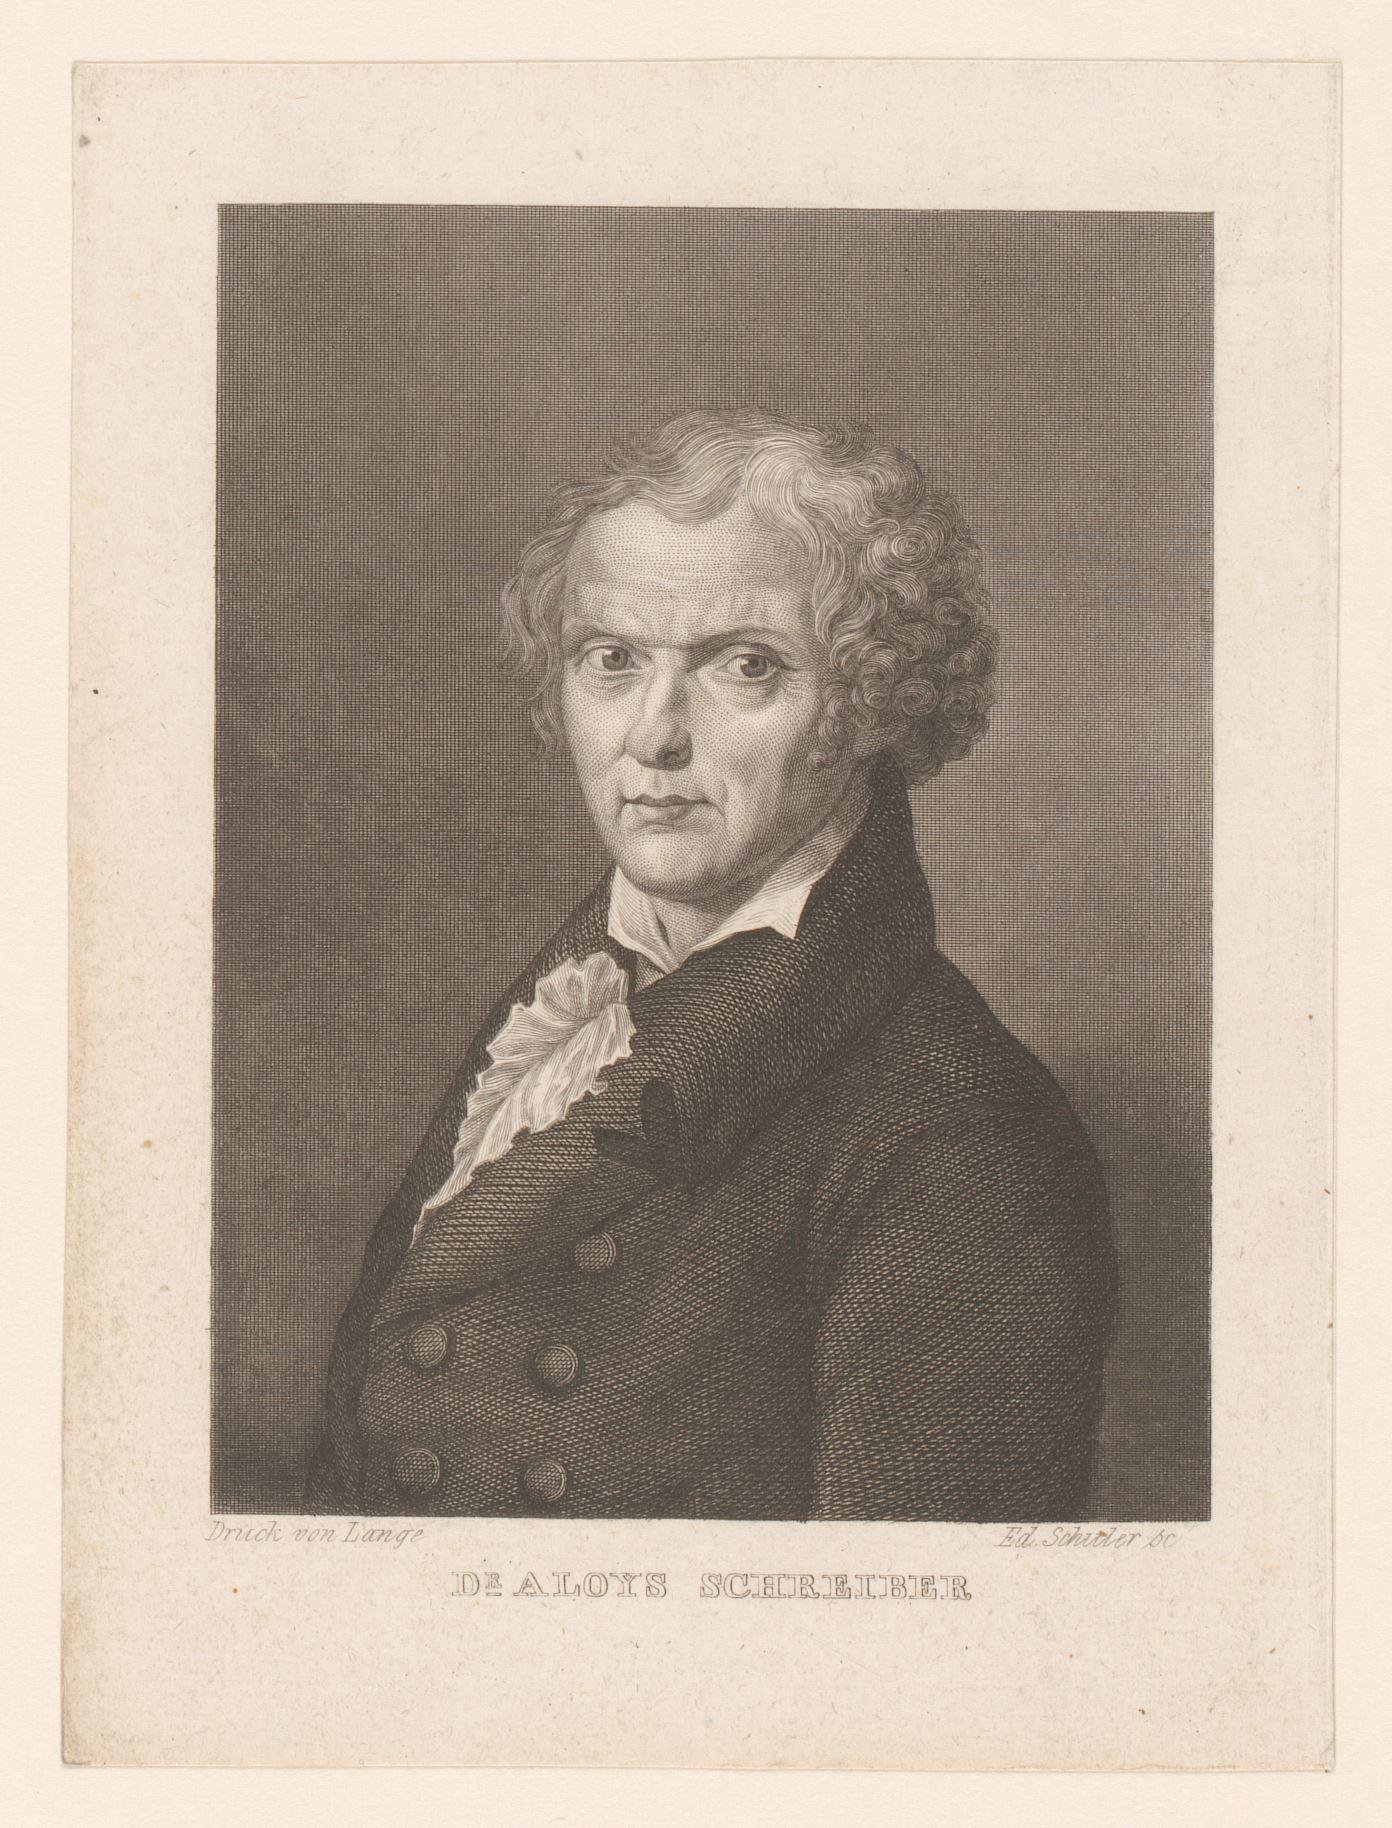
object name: print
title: Portret van Aloys Schreiber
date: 1816-1882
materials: paper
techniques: engraving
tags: historical persons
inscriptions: collector's mark: Lugt 2228